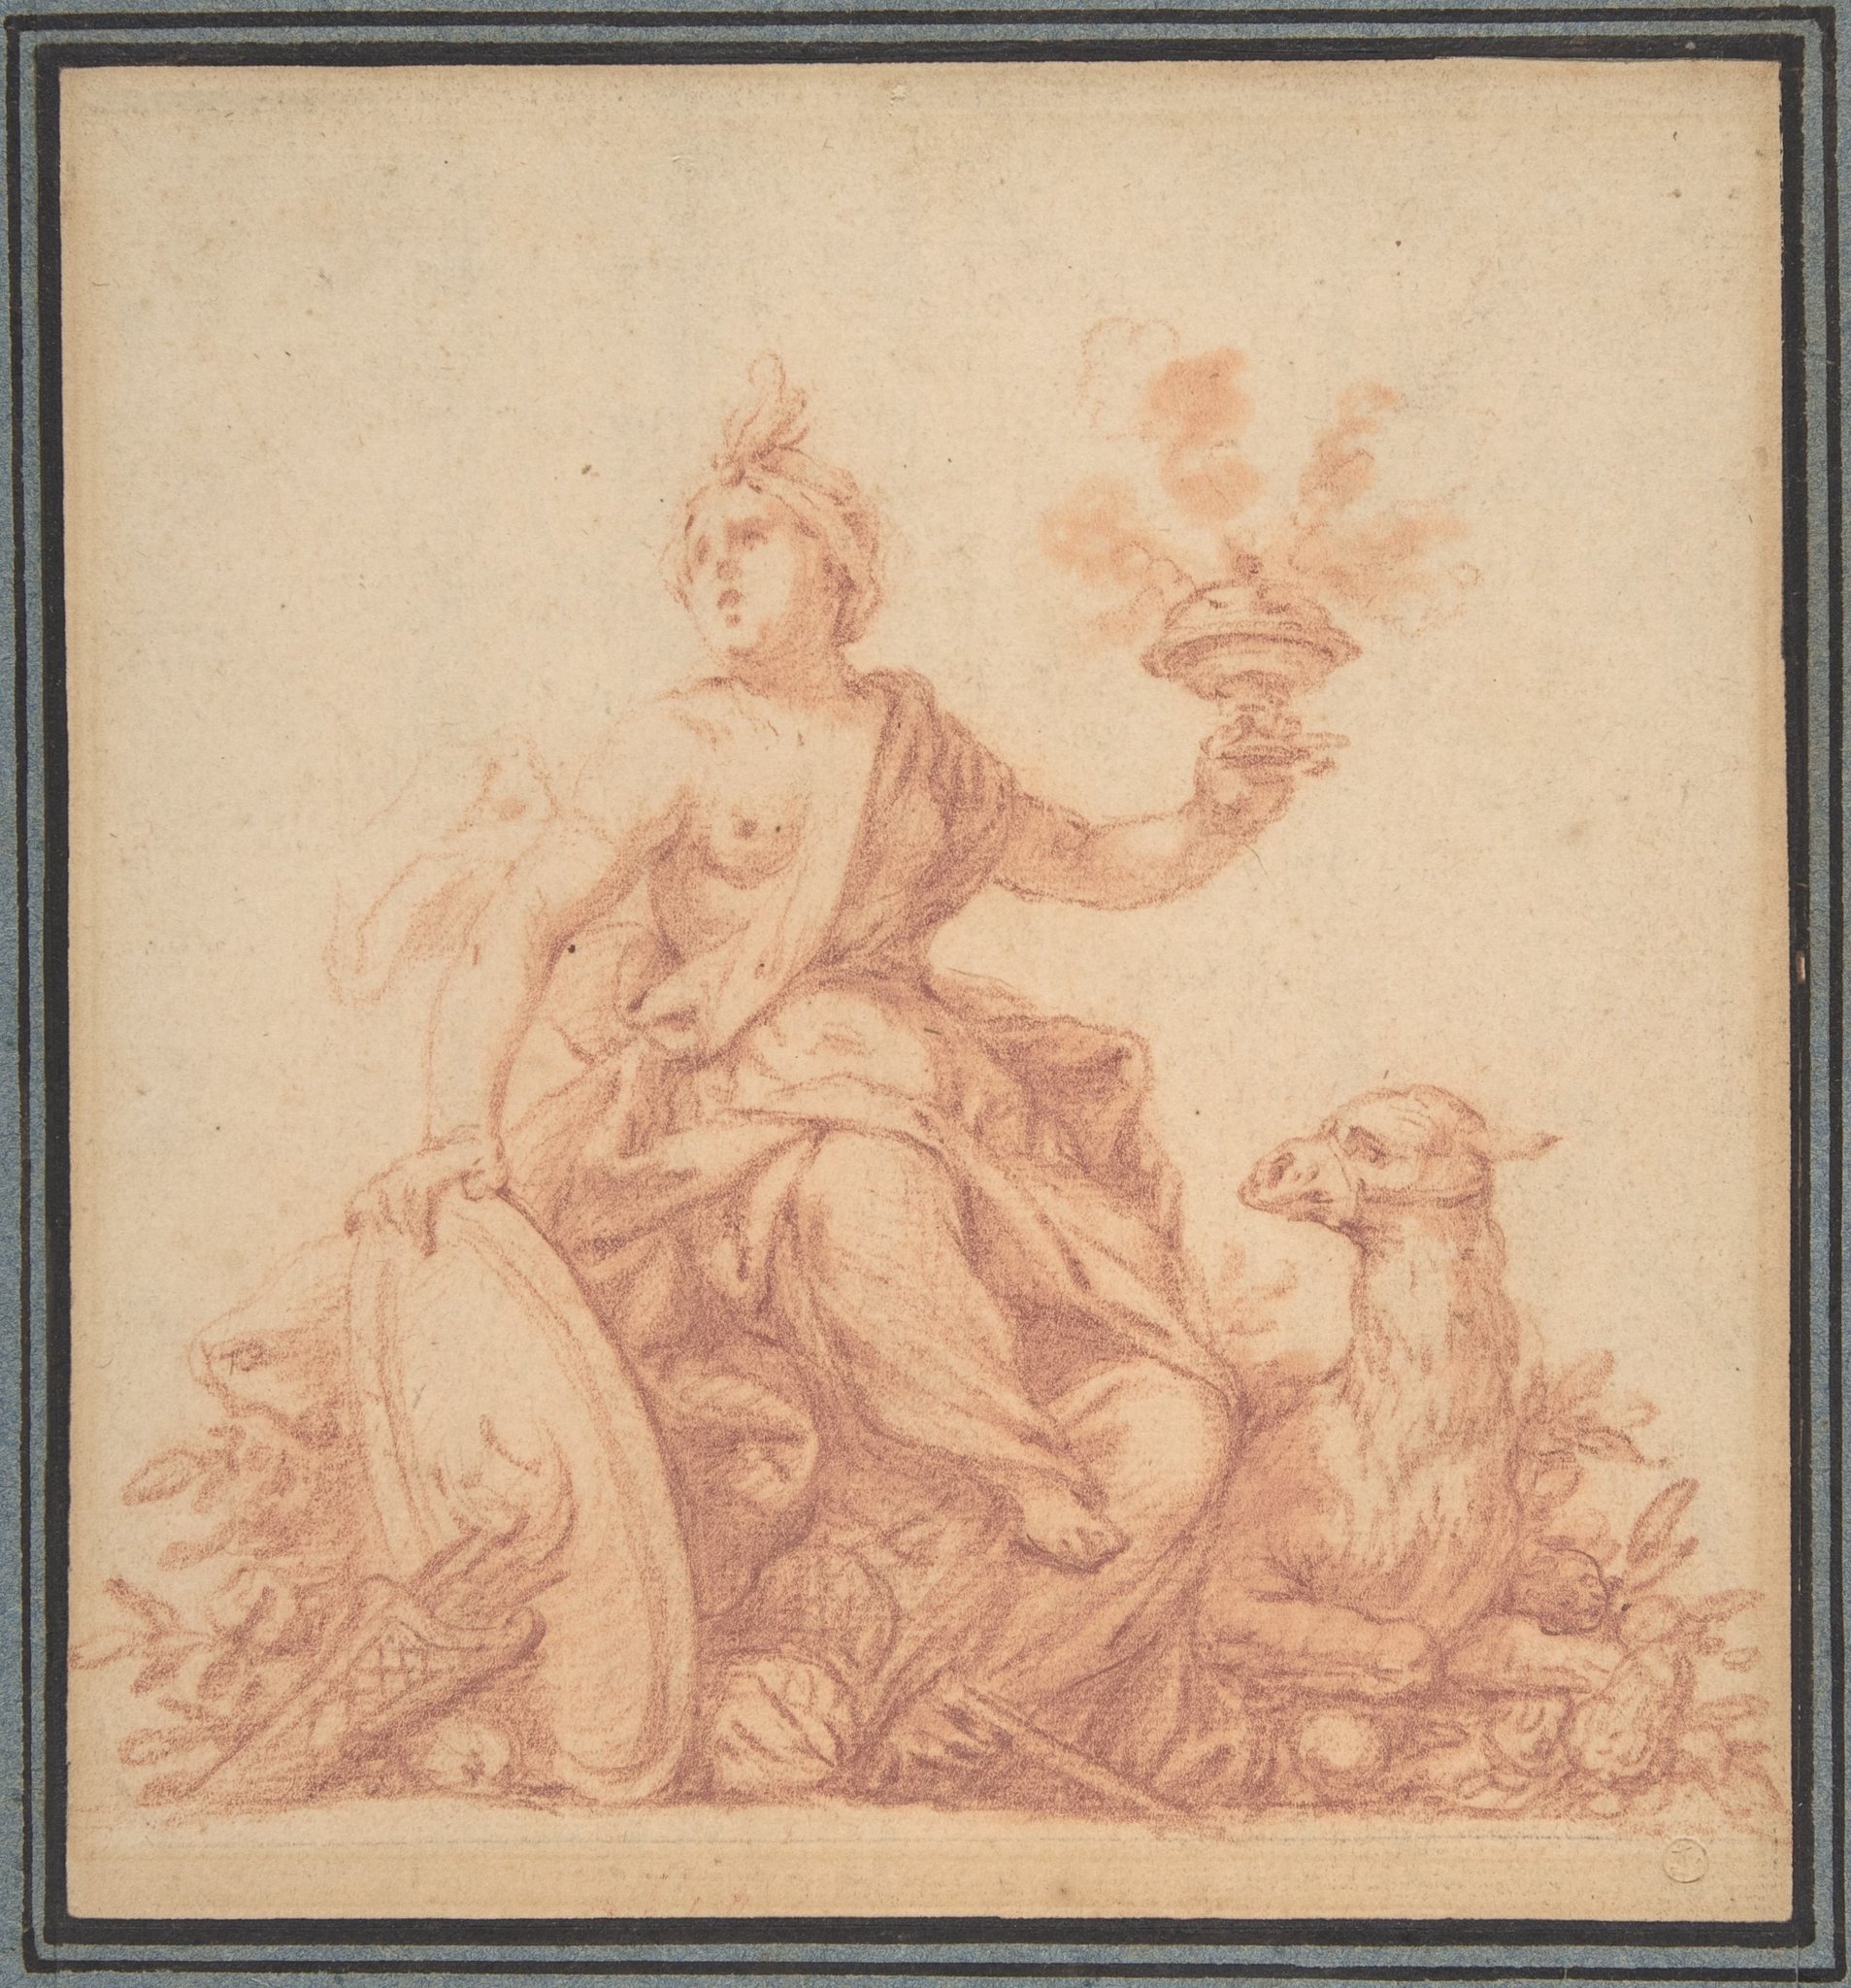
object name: drawing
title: Allegory of Asia, from the Four Continents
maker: anonymous, french, 18th century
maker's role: artist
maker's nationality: french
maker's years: 1700-1800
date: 1701-1800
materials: chalk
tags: animals,women